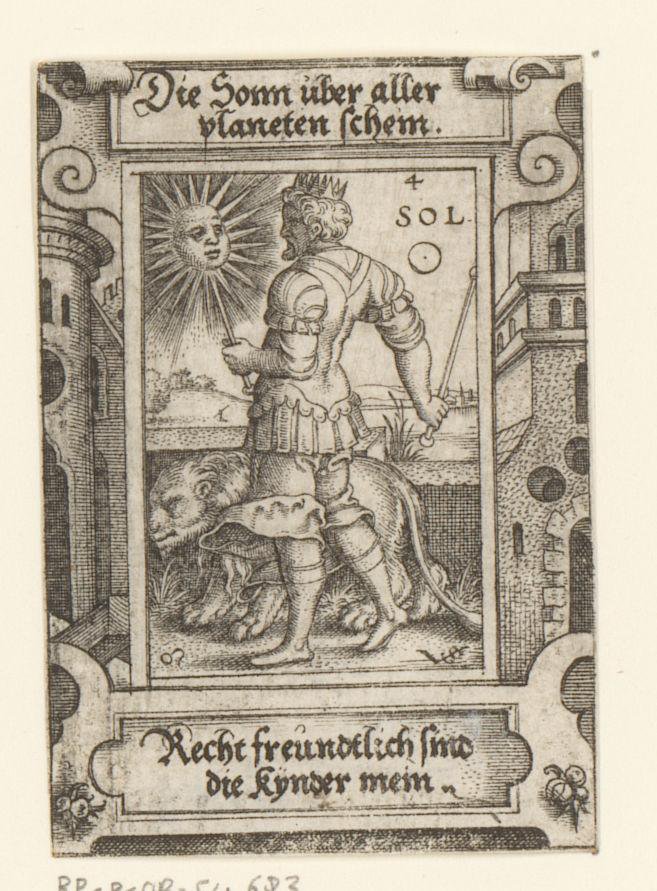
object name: print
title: Sol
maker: virgilius solis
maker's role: draughtsman, print maker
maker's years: 1514-1562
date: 1524-1562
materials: paper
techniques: engraving, etching, intaglio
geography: nuremberg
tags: apollo as sun-god, i.e. sol (helius), titan, sun as celestial body, leo (zodiacal sign of july)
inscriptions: number: ‘55’, collector's mark: Lugt 2228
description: Maakt deel uit van een serie van zeven prenten met personificaties van de planeten met tekens van de dierenriem in een rolwerk omlijsting.